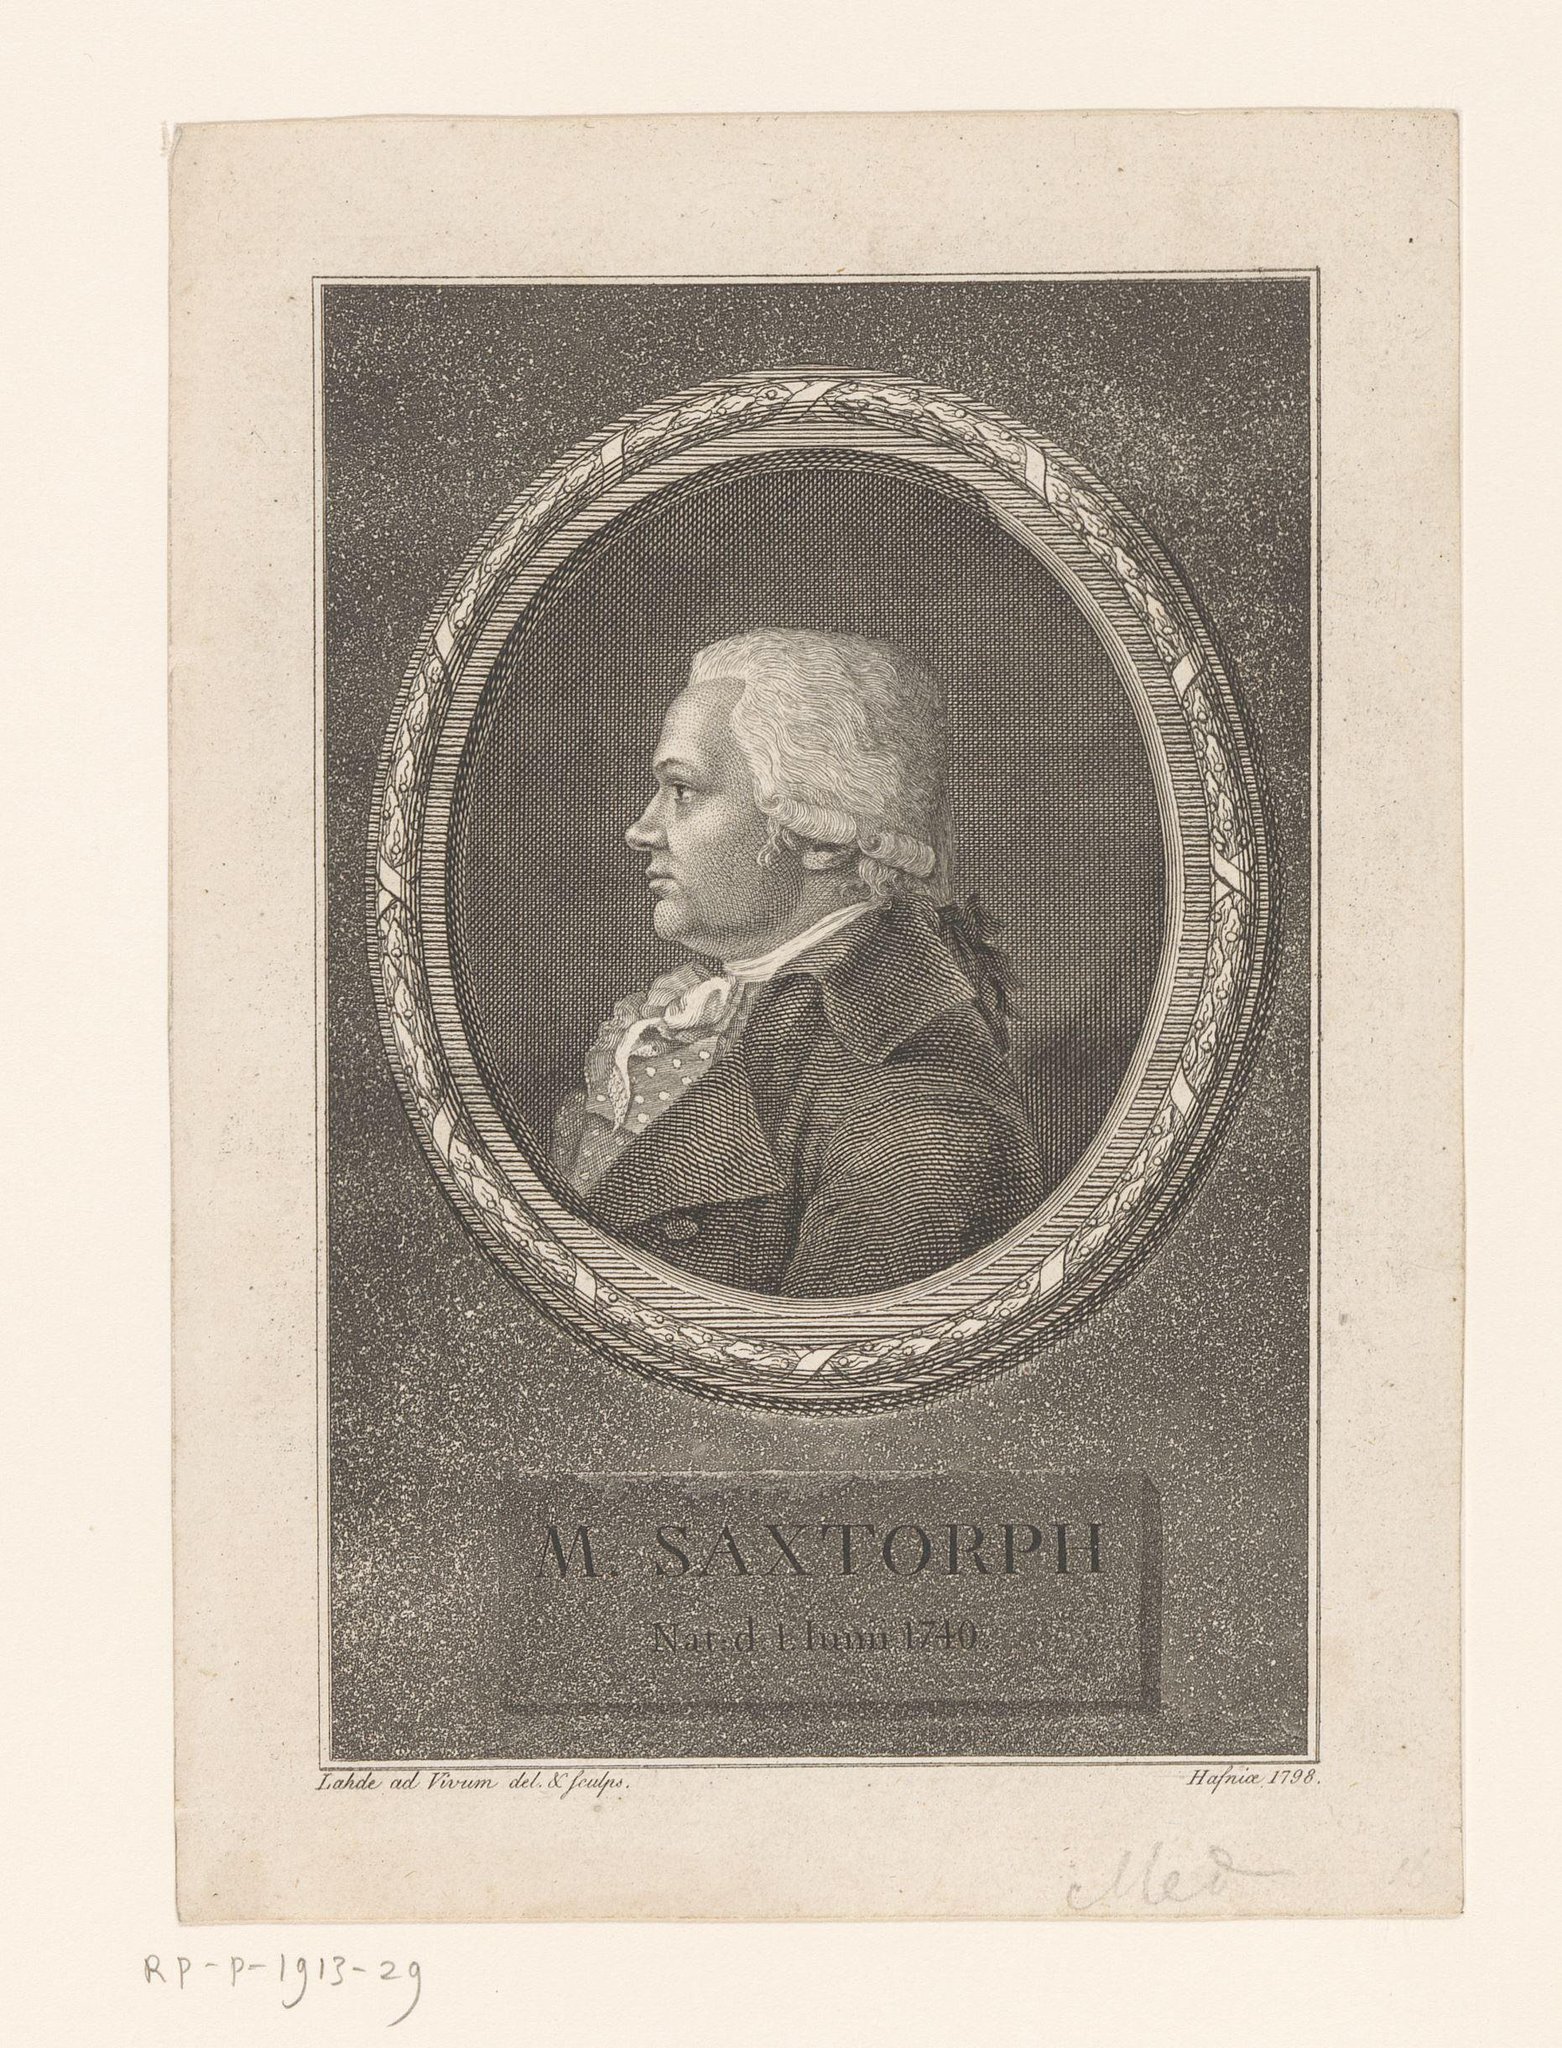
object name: print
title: Portret van Matthias Saxtorph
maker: gerhard ludwig lahde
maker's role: goldsmith, print maker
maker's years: 1765-1833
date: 1798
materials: paper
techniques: aquatint, engraving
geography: copenhagen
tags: historical persons, physician, doctor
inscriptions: collector's mark: Lugt 2228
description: Portret van Matthias Saxtorph, Deens gynaecoloog.